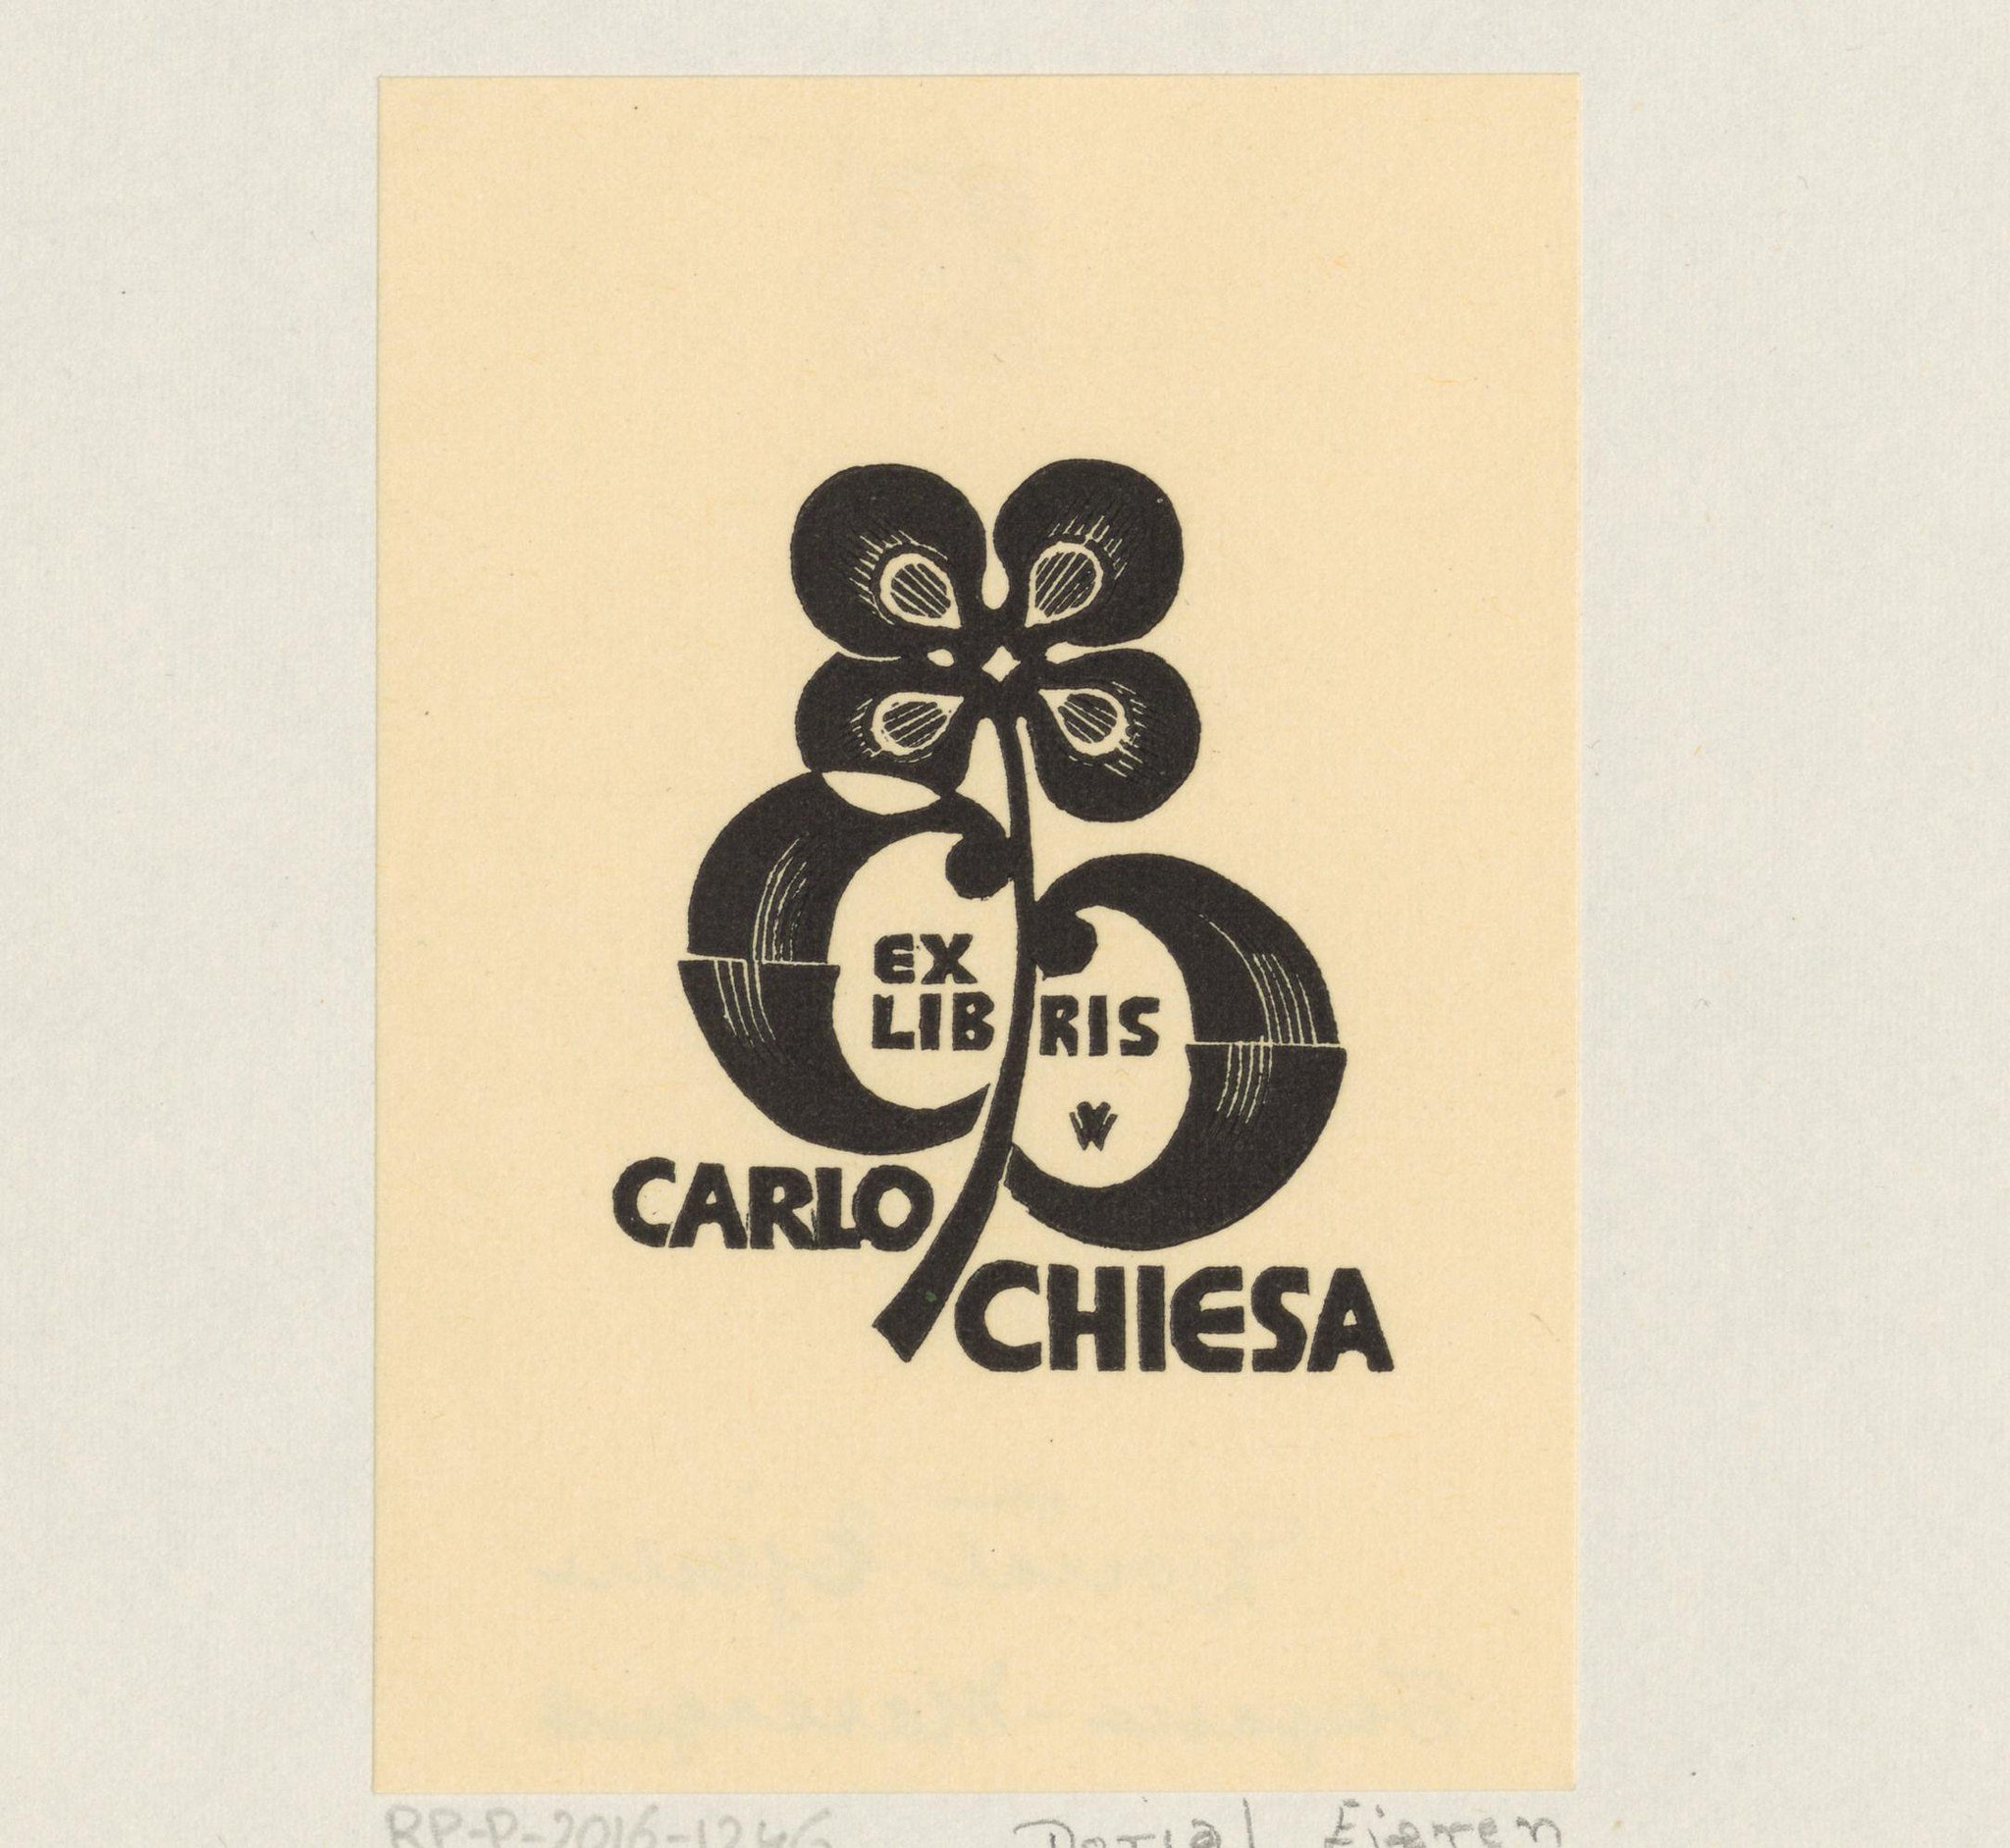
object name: bookplate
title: Ex libris van Carlo Chiesa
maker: Anonymous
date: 1900-1999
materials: paper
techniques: woodcut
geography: hungary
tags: plants and herbs: clover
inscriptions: inscription: ‘Dorial Ejeren / Lugana-Marrague (?)’